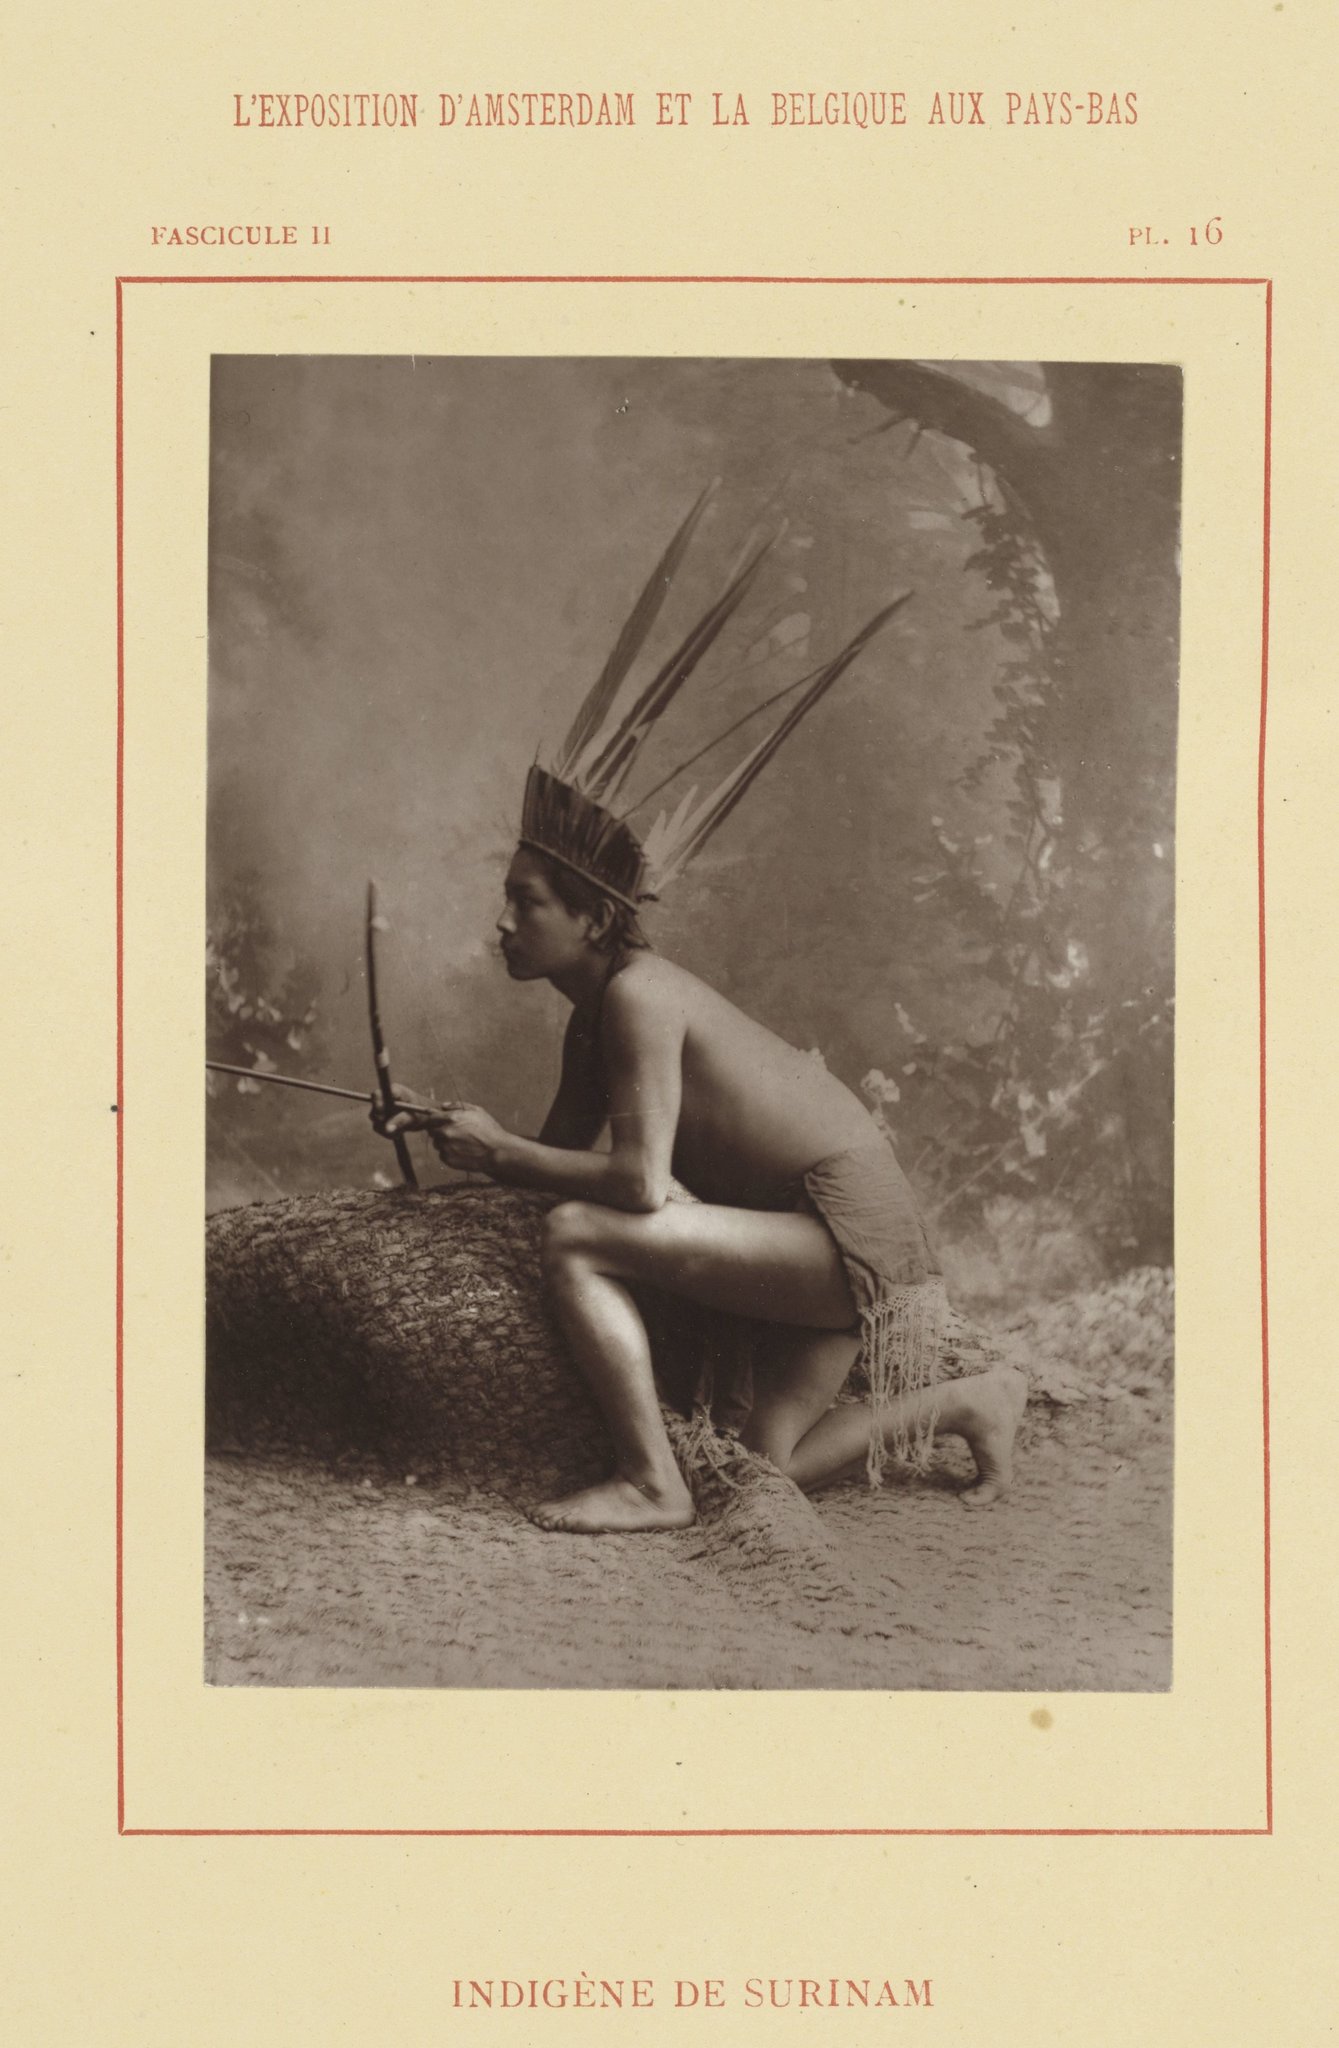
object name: photograph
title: Indigène de Surinam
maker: théophile fumière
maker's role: publisher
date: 1883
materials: cardboard, paper, photographic support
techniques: woodburytype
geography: amsterdam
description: Fascicule II pl. 16 uit L'exposition d'Amsterdam et la Belgique aux Pays-Bas, 1883.